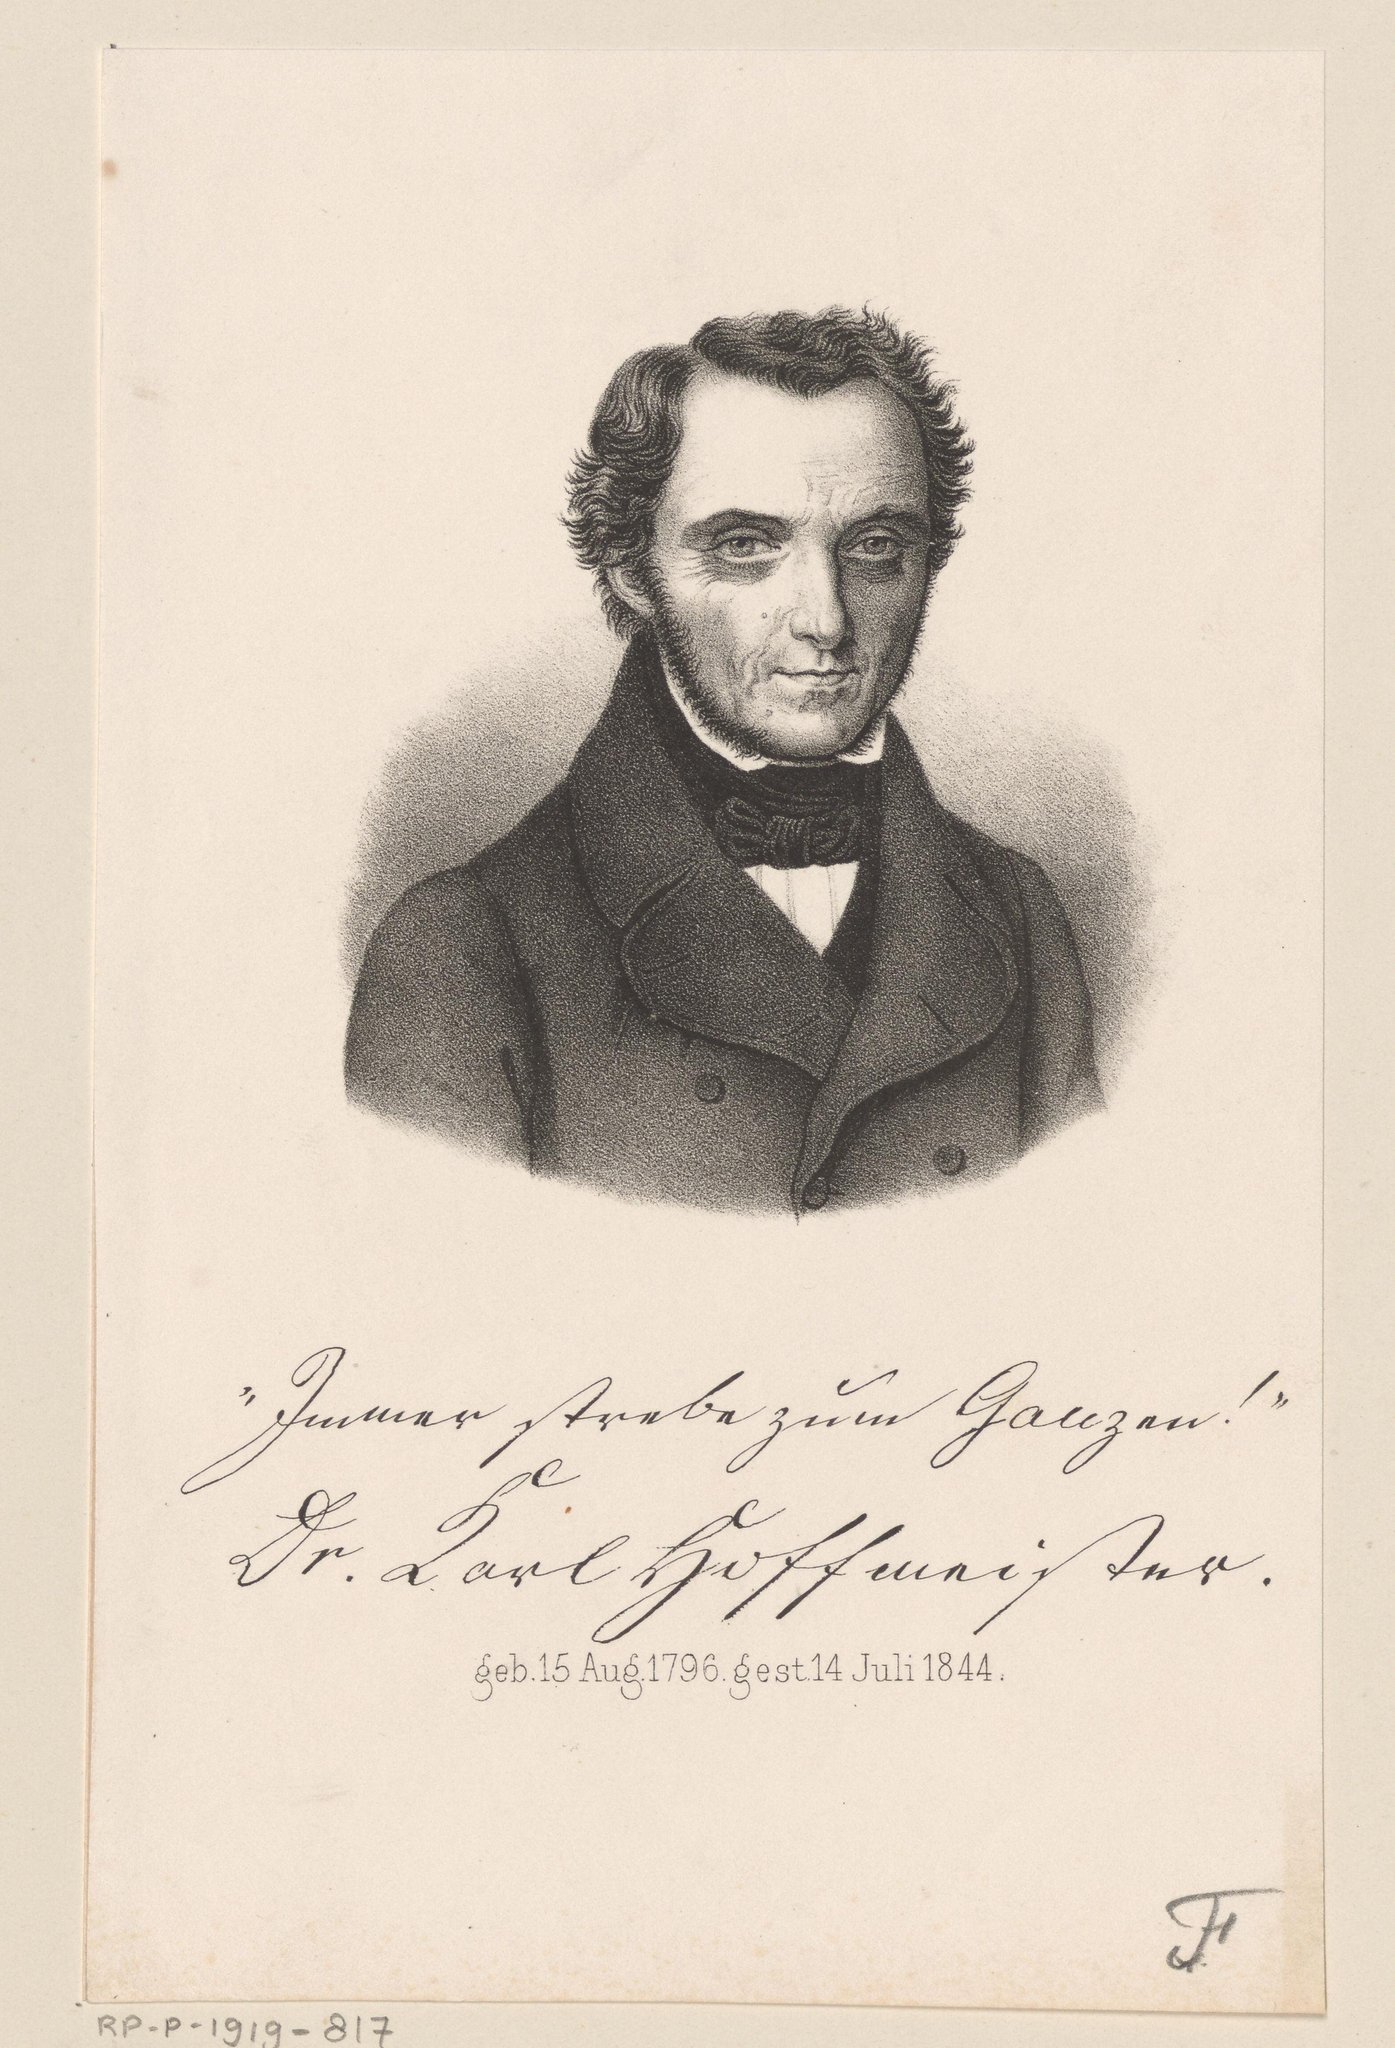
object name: print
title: Portret van Karl Hoffmeister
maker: Anonymous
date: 1844-1860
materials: paper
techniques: lithograph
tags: cologne, scholar, philosopher, historical persons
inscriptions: collector's mark: Lugt 2228